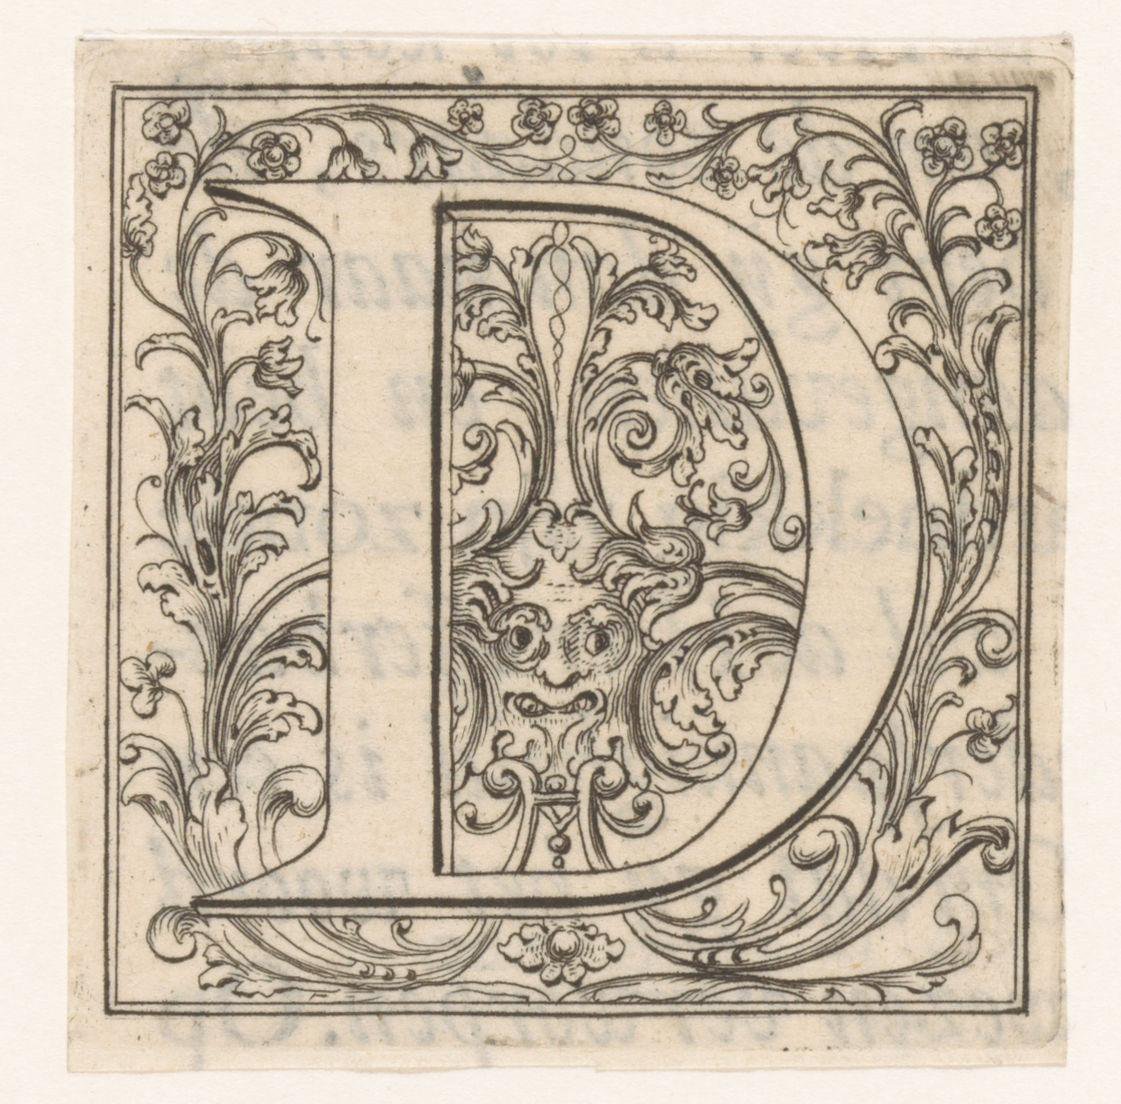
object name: book illustration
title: Letter D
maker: Anonymous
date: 1700-1799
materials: paper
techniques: etching, letterpress printing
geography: netherlands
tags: fancy letters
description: Letter D tegen een achtergrond met vlechtwerk en een masker.